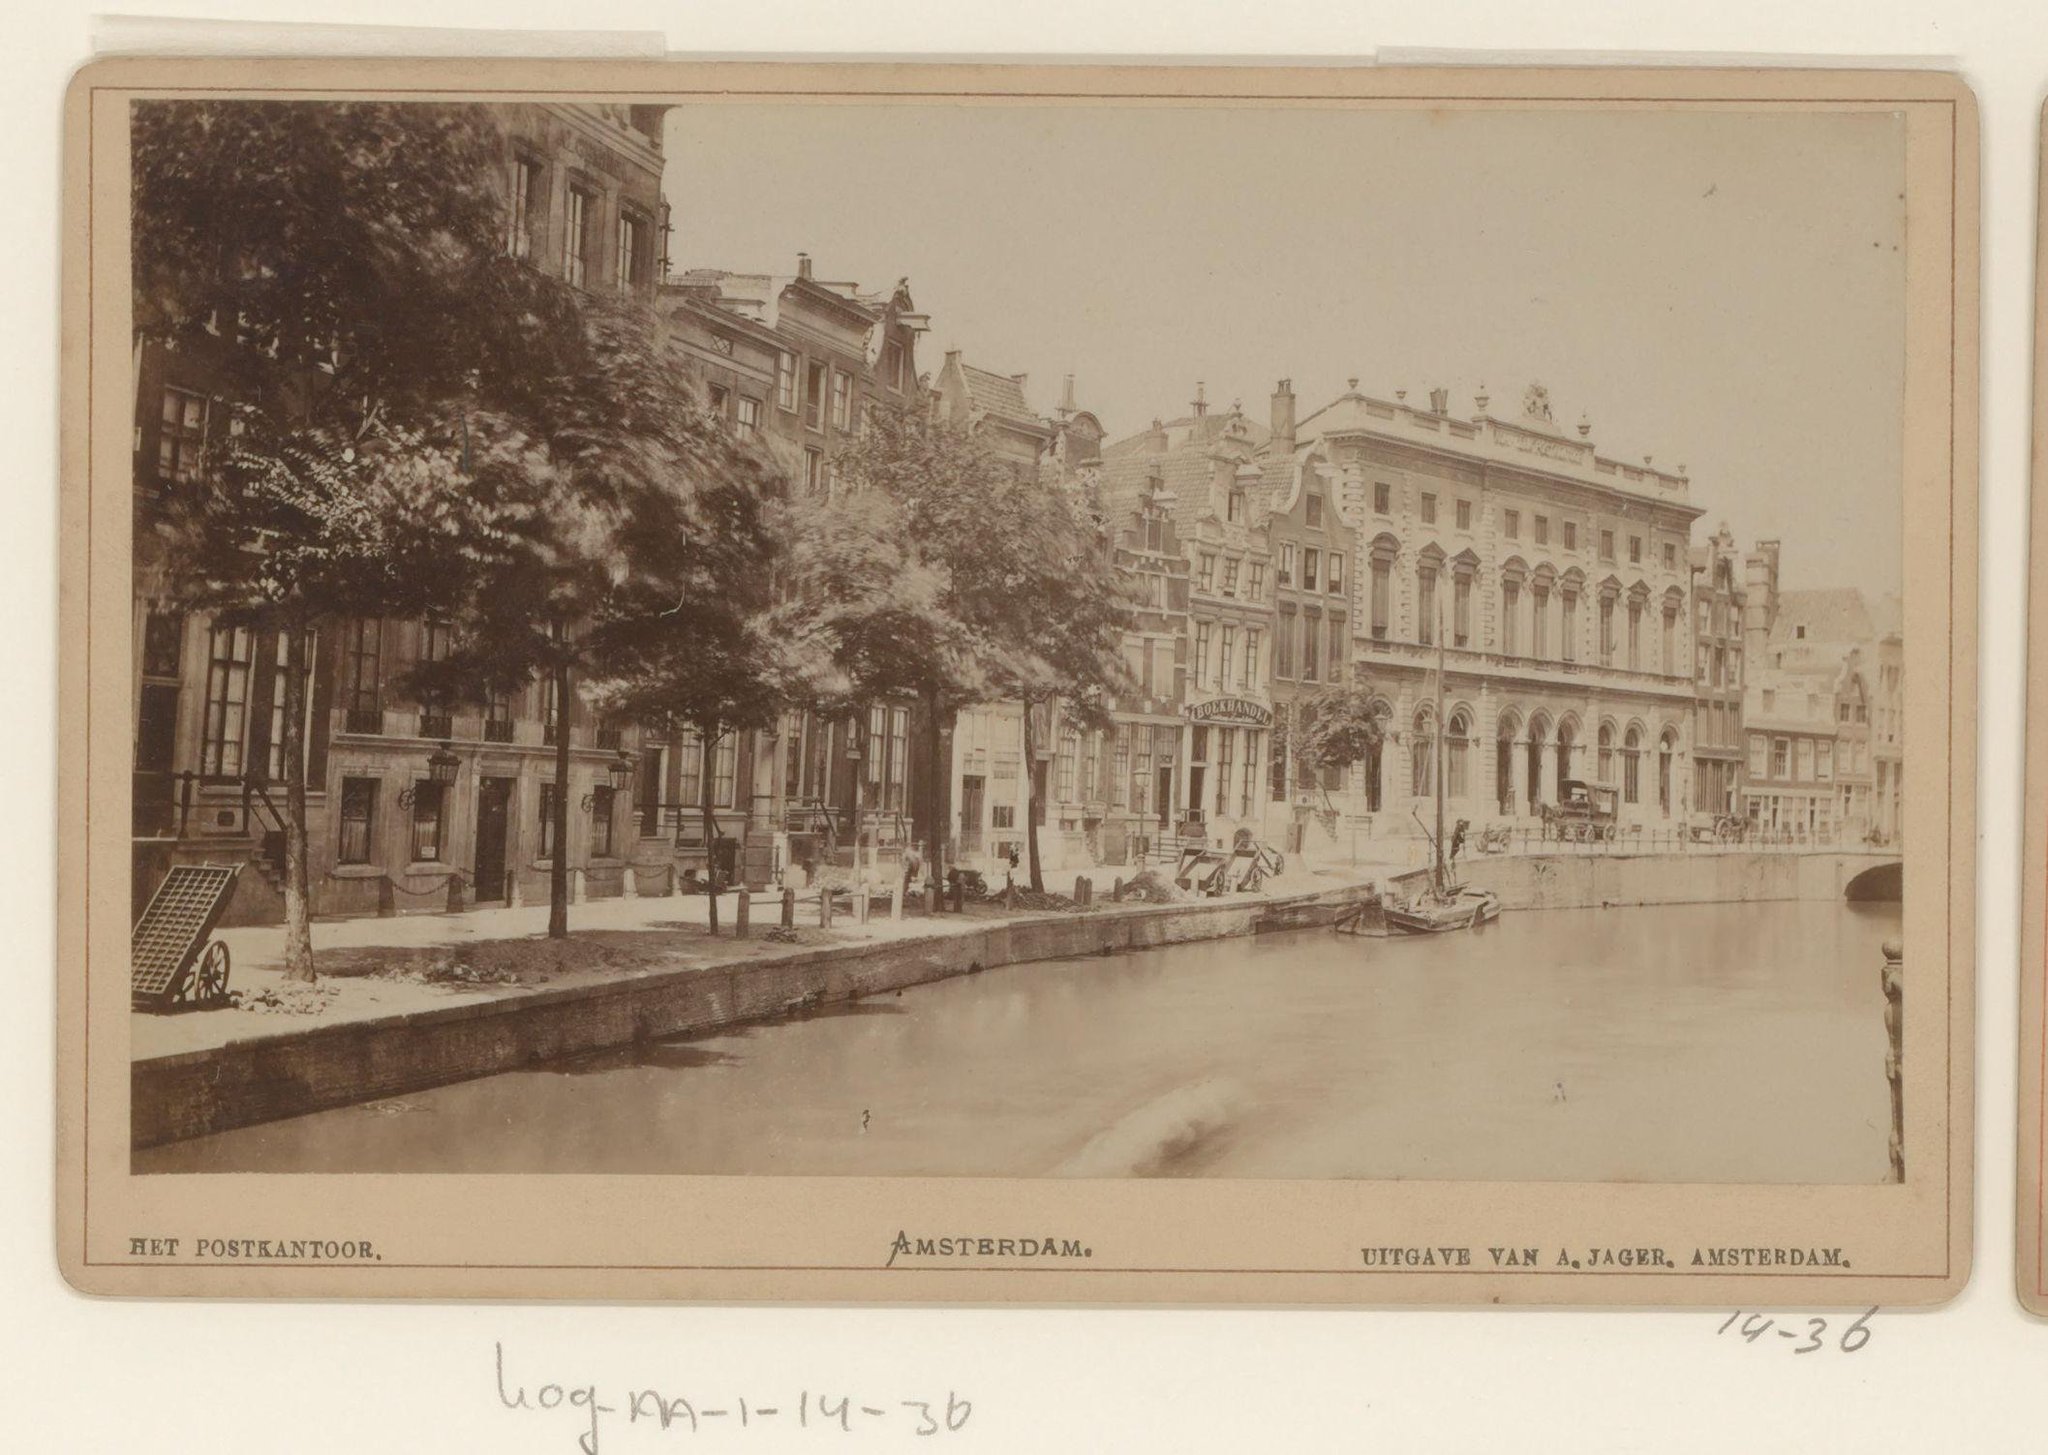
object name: cabinet photograph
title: Gezicht op het oude postkantoor aan de Nieuwezijds Voorburgwal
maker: andries jager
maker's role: publisher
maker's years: 1825-1905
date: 1875-1896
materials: cardboard, paper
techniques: albumen print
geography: amsterdam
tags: post-office, city-view in general; 'veduta', canal, street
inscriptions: inscription: ‘93. / Oude Postkantoor voor de demping’, stamp: ‘Gebr. Douwes / Atelier / Grimburgwal 15 / Amsterdam.’, collector's mark: ‘14.36’ Lugt 1641b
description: Onderwerpsrubriek binnen de Atlas Amsterdam: Verhulststraat (Johannes), Viaducten, Vierwindenstraat, Vinkenbuurt, Vinkenpad, Vinkenstraat, Vischsteeg, Vliegendesteeg, Voetboogstraat, Volewijk, Vondelstraat, Voorburgwal (N.Z.).